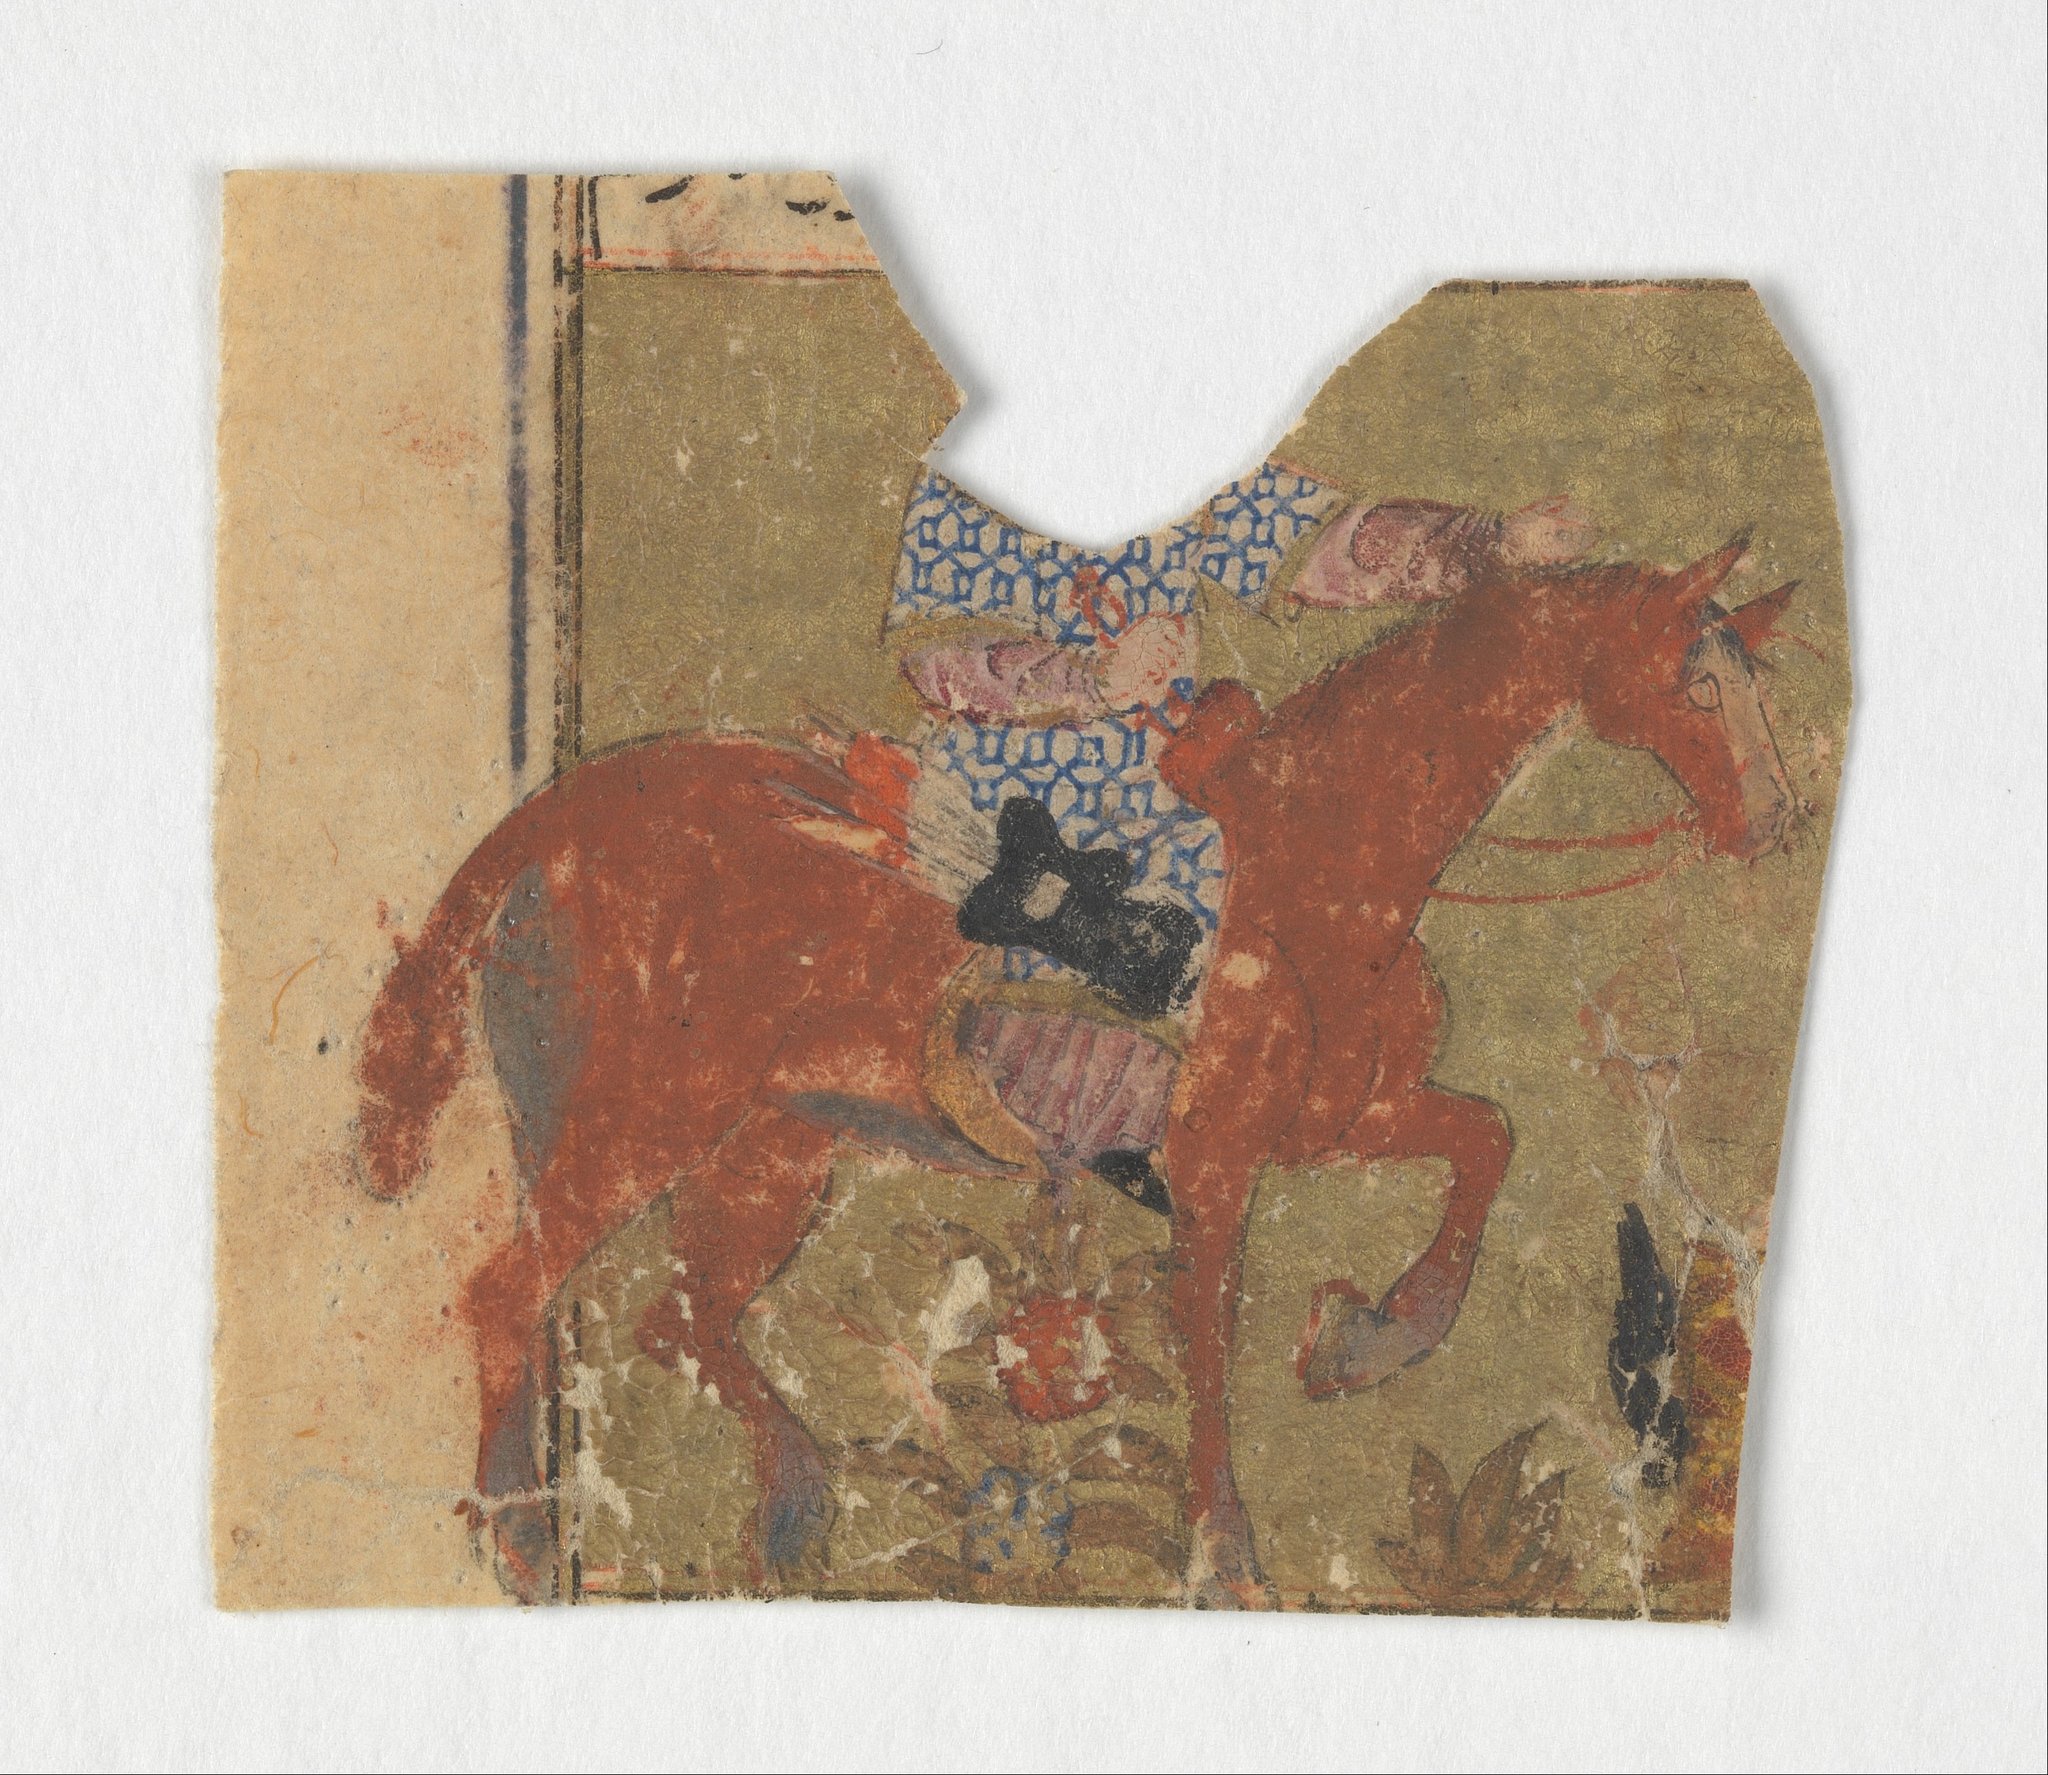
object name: folio from an illustrated manuscript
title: "Horseman and Fragment of Text", Folio from a Shahnama (Book of Kings)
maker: abu'l qasim firdausi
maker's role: author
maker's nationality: iranian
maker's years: 935-1020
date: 1330-1340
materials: gold, ink, paper, watercolor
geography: iran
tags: human figures,horses